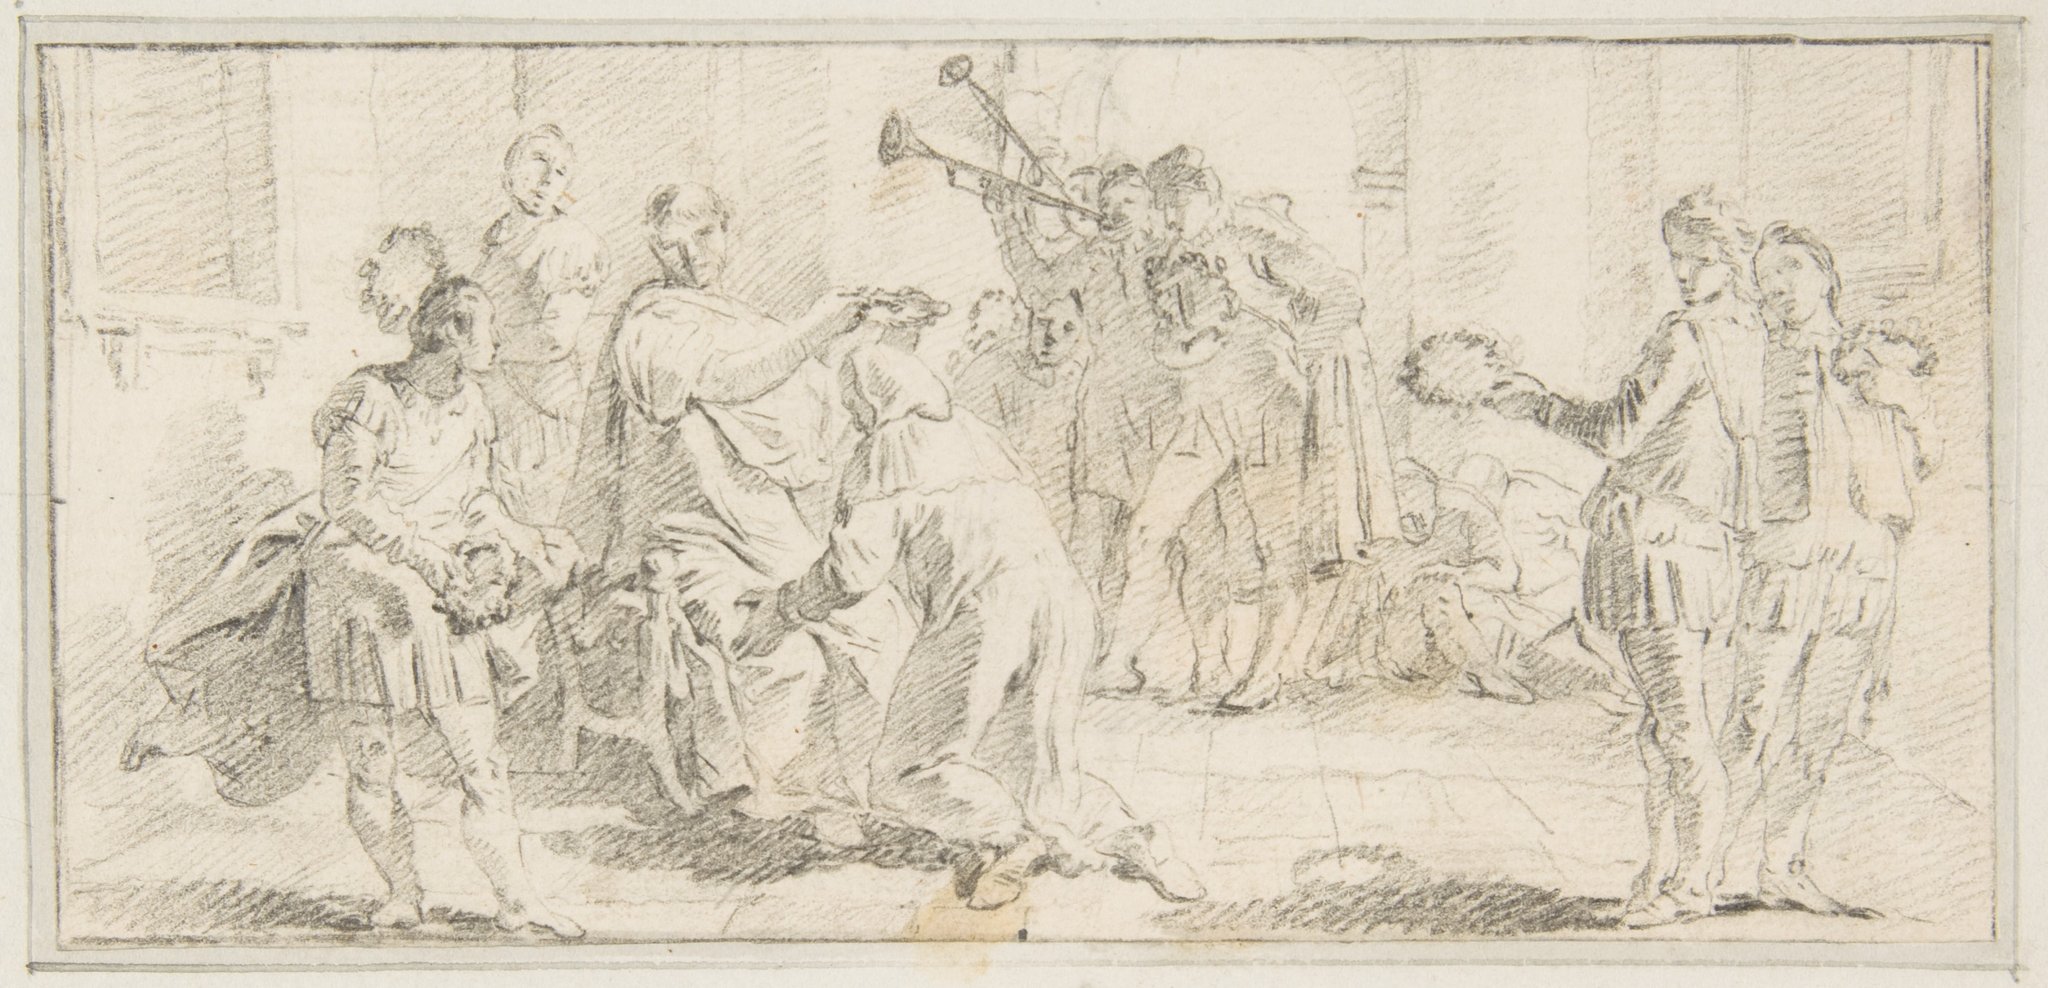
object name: drawing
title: Illustration for a Book: Allegorical Scene of Coronation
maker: giovanni battista tiepolo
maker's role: artist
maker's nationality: italian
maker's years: 1696-1770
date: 1696-1770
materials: chalk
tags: men,ceremony,musicians